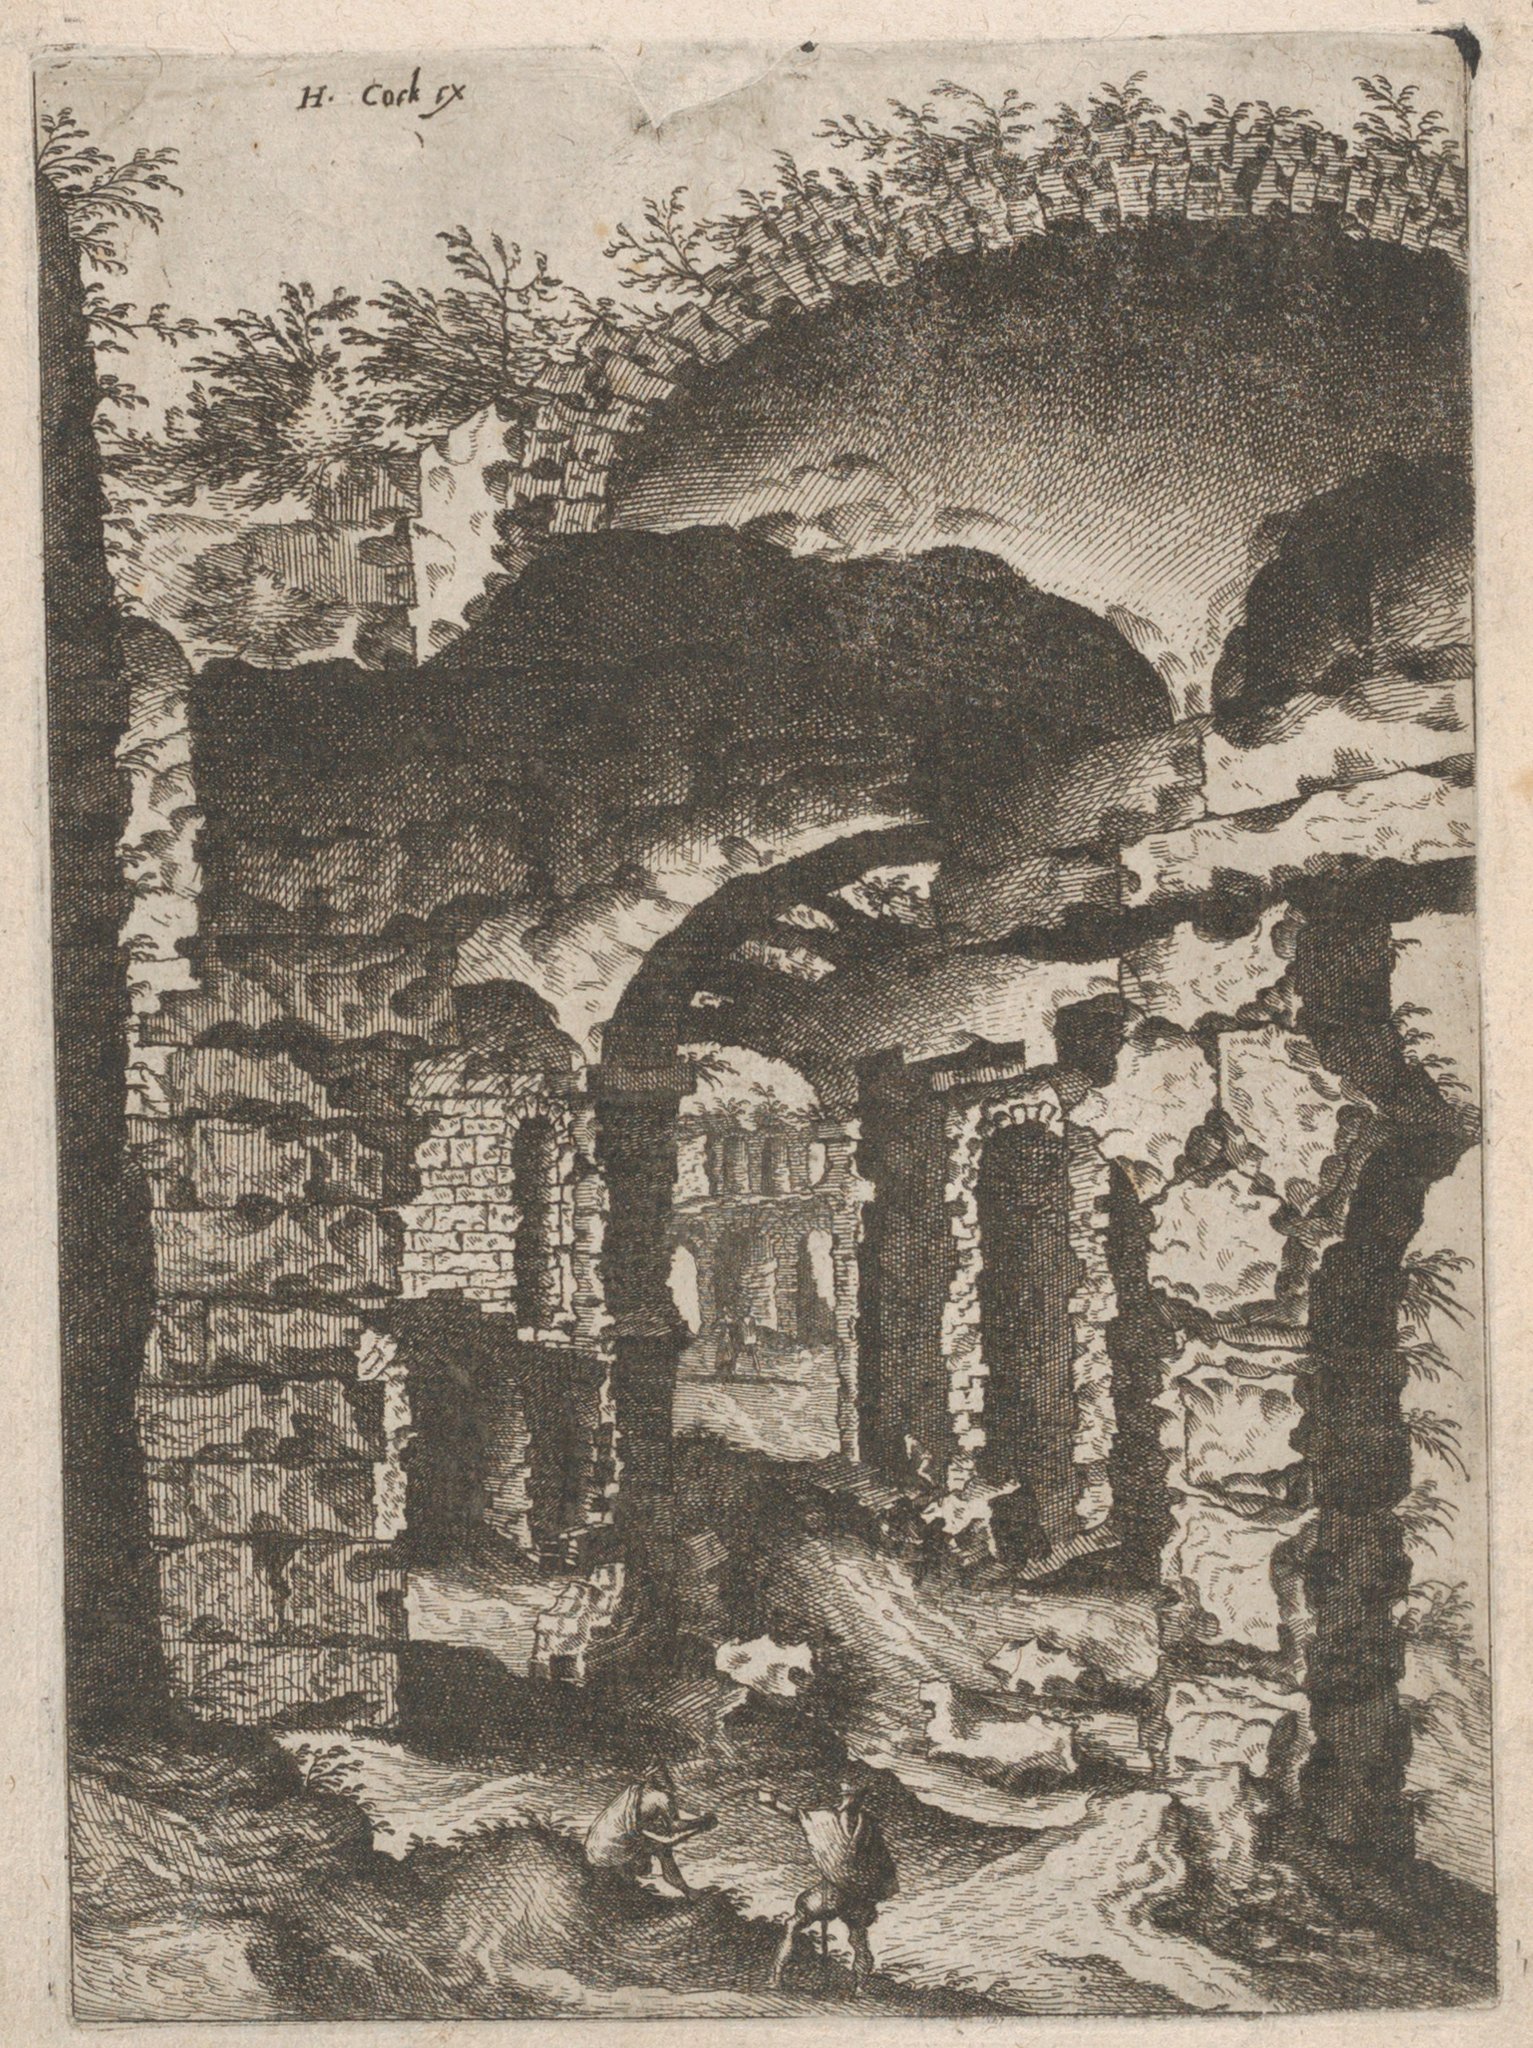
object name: print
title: Vaults with Bosse Blocks, from "Roman Ruins and Buildings"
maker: johannes van doetecum i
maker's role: artist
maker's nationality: netherlandish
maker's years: 1528-1605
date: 1562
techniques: engraving, etching